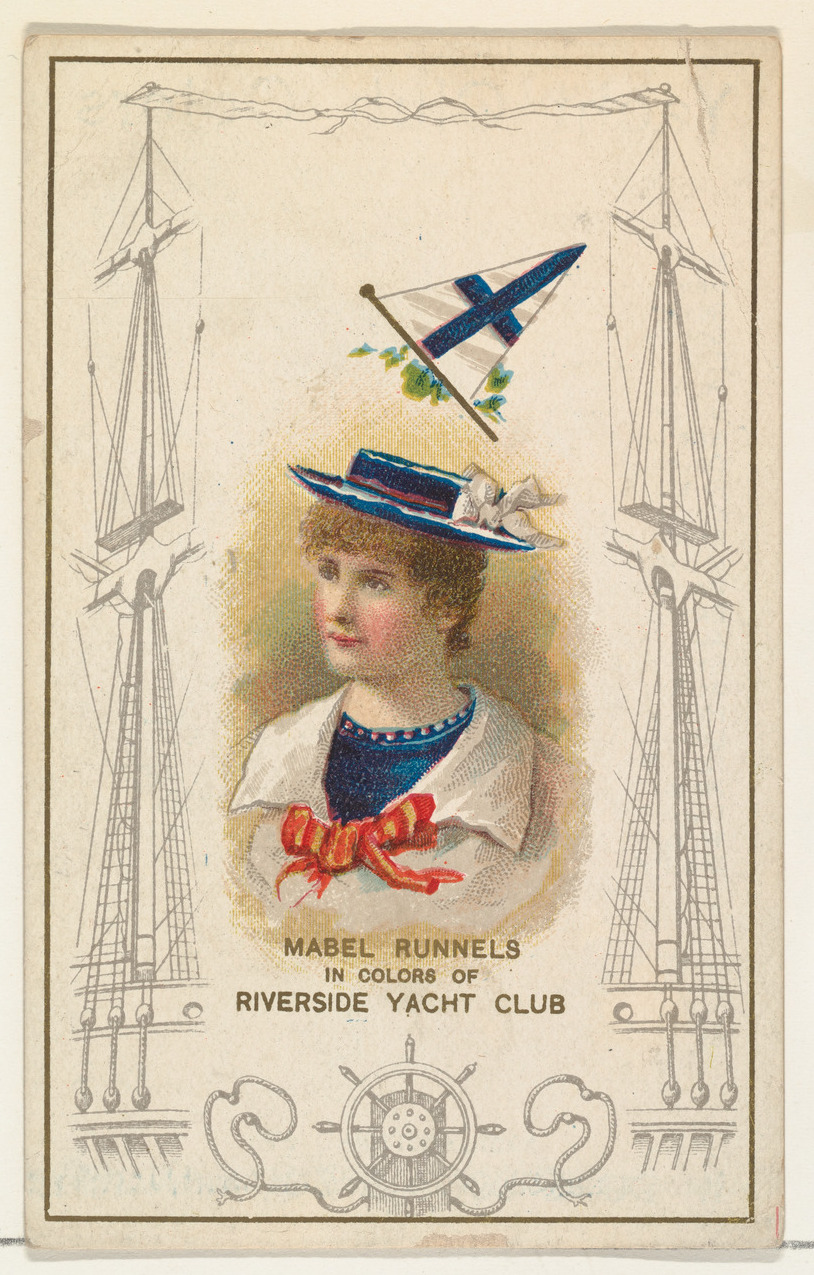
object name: print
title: Mabel Runnels in Colors of Riverside Yacht Club, from the Yacht Colors of the World series (N140) issued by Duke Sons & Co. to promote Honest Long Cut Tobacco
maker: w. duke, sons & co.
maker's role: publisher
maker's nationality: american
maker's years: 1870-1920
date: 1890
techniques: color lithograph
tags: portraits,women,flags